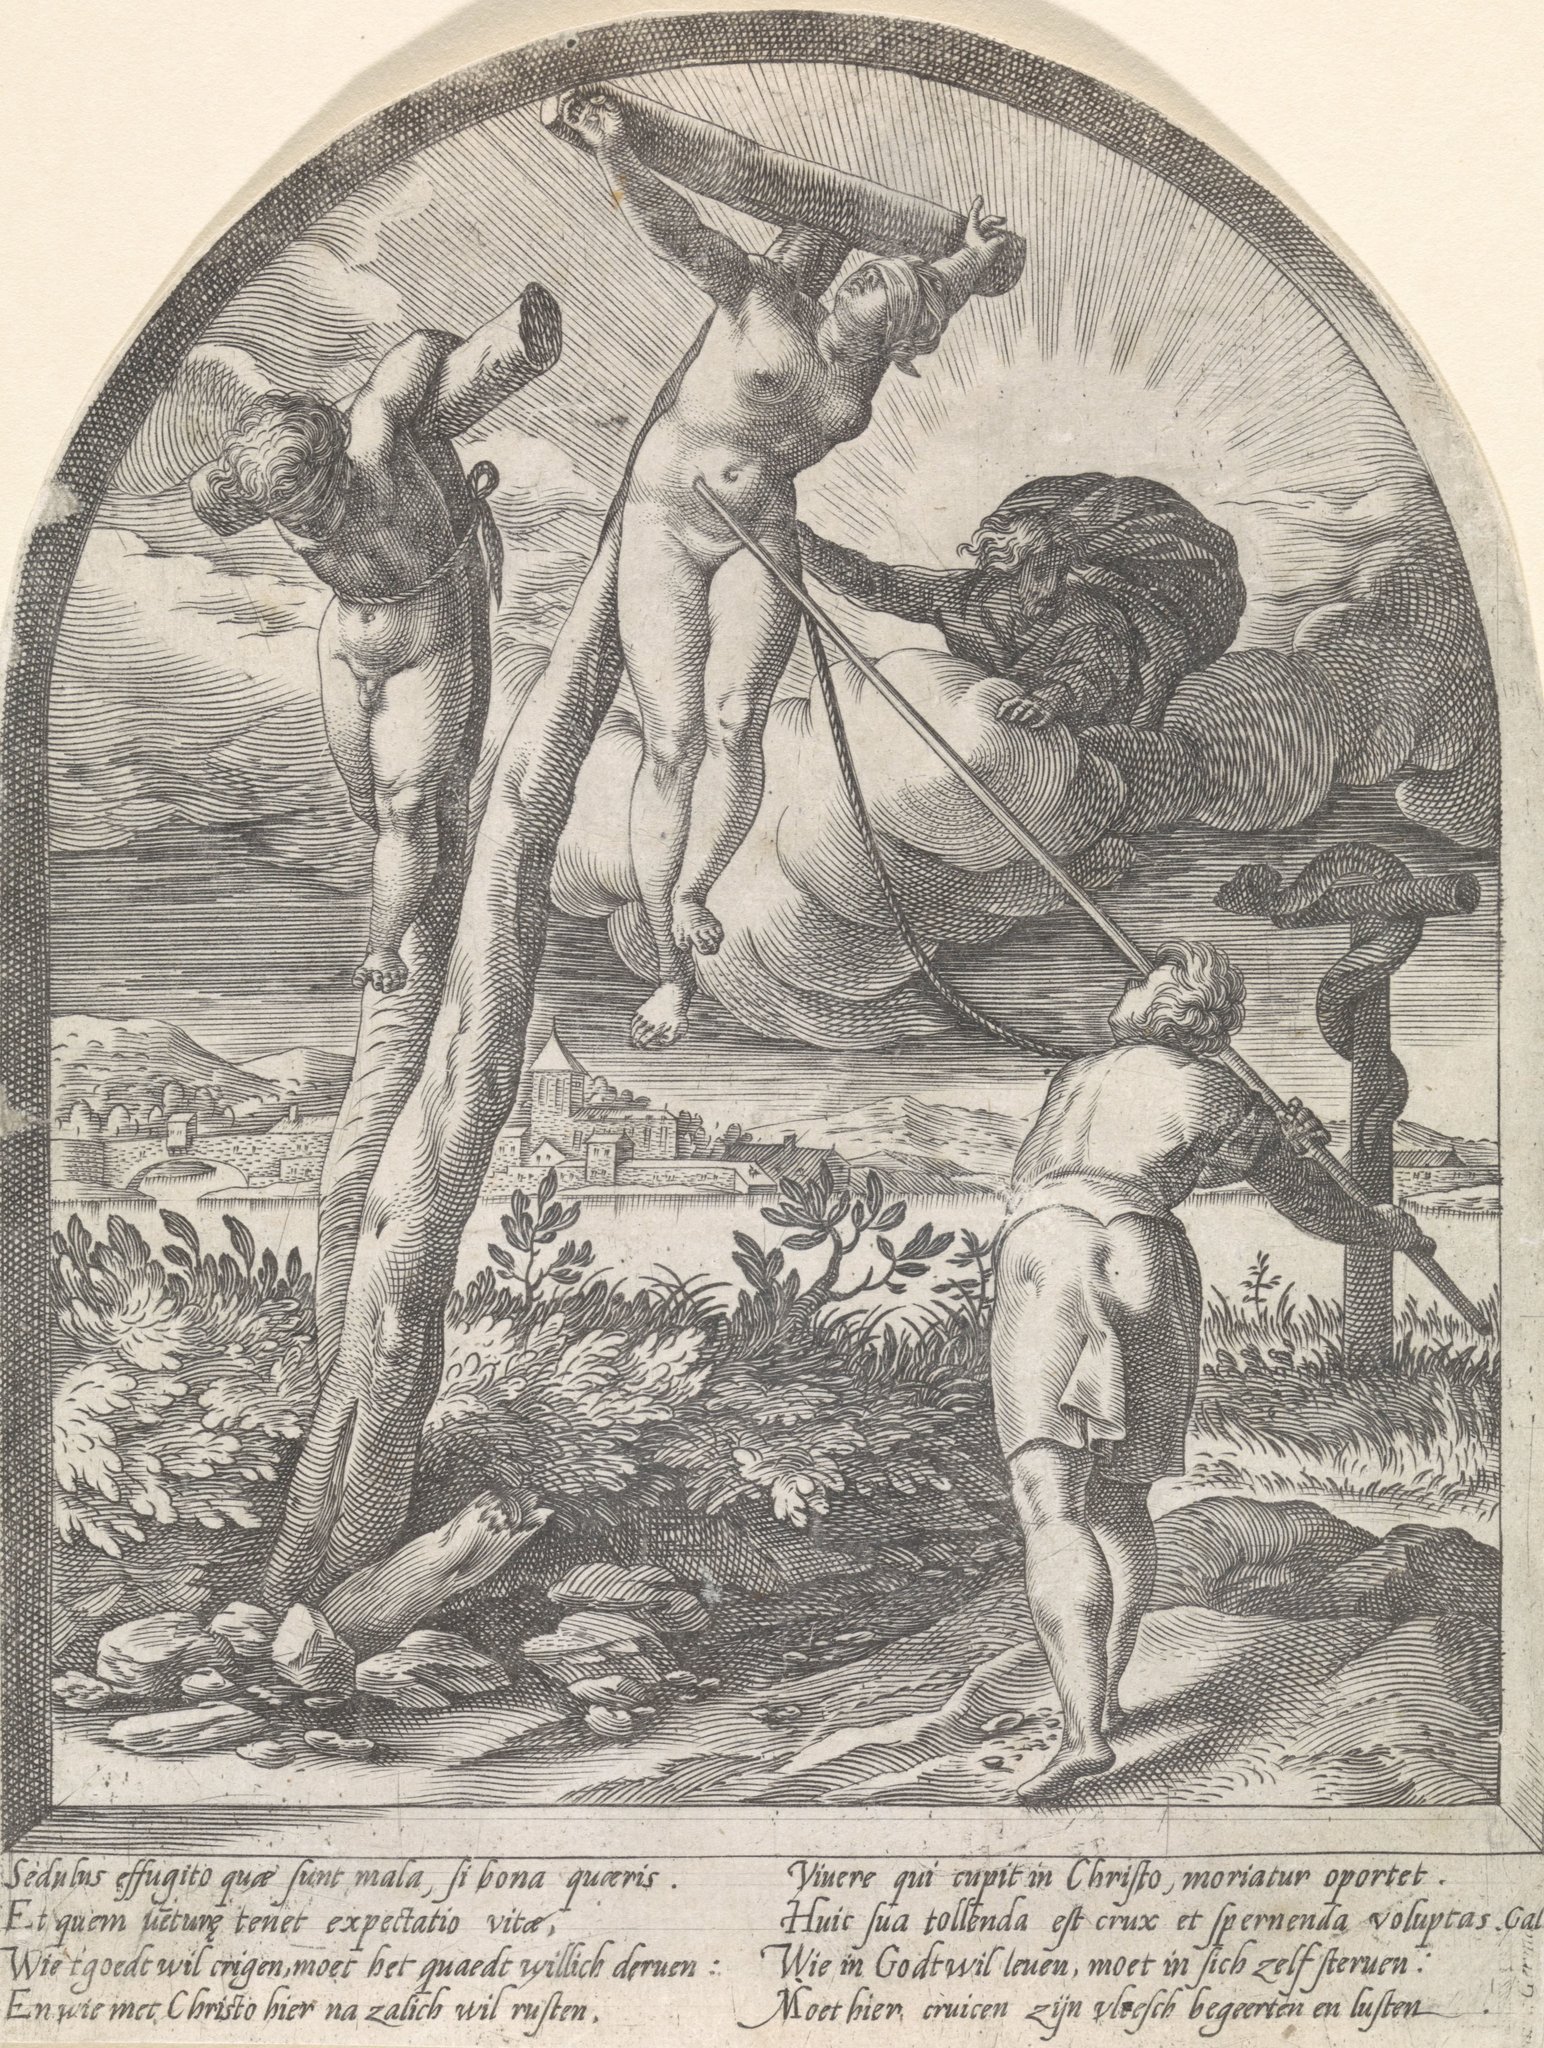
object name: print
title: De geestelijke jachten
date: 1578-1582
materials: paper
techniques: engraving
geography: haarlem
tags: the cross ~ symbols of christ, epistle of paul to the galatians (+ variant), doctrine on original sin, and redemption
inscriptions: collector's mark: Lugt 2228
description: Allegorische illustratie van de Bijbeltekst in Gal. 5:24 waarin staat dat wie Christus toebehoort zijn eigen natuur met alle hartstocht en begeerte aan het kruis heeft geslagen. De Begeerte hangt in de gedaante van een naakte en geblinddoekte vrouw en man aan twee kruisen. Een man doorboort de zij van de vrouw met een speer. Rechts een slang op een kruis als symbool van het gekruisigde kwaad. Op de wolken Christus. Onder de voorstelling verklarende verzen en een verwijzing naar de Bijbeltekst in het Latijn en het Nederlands.